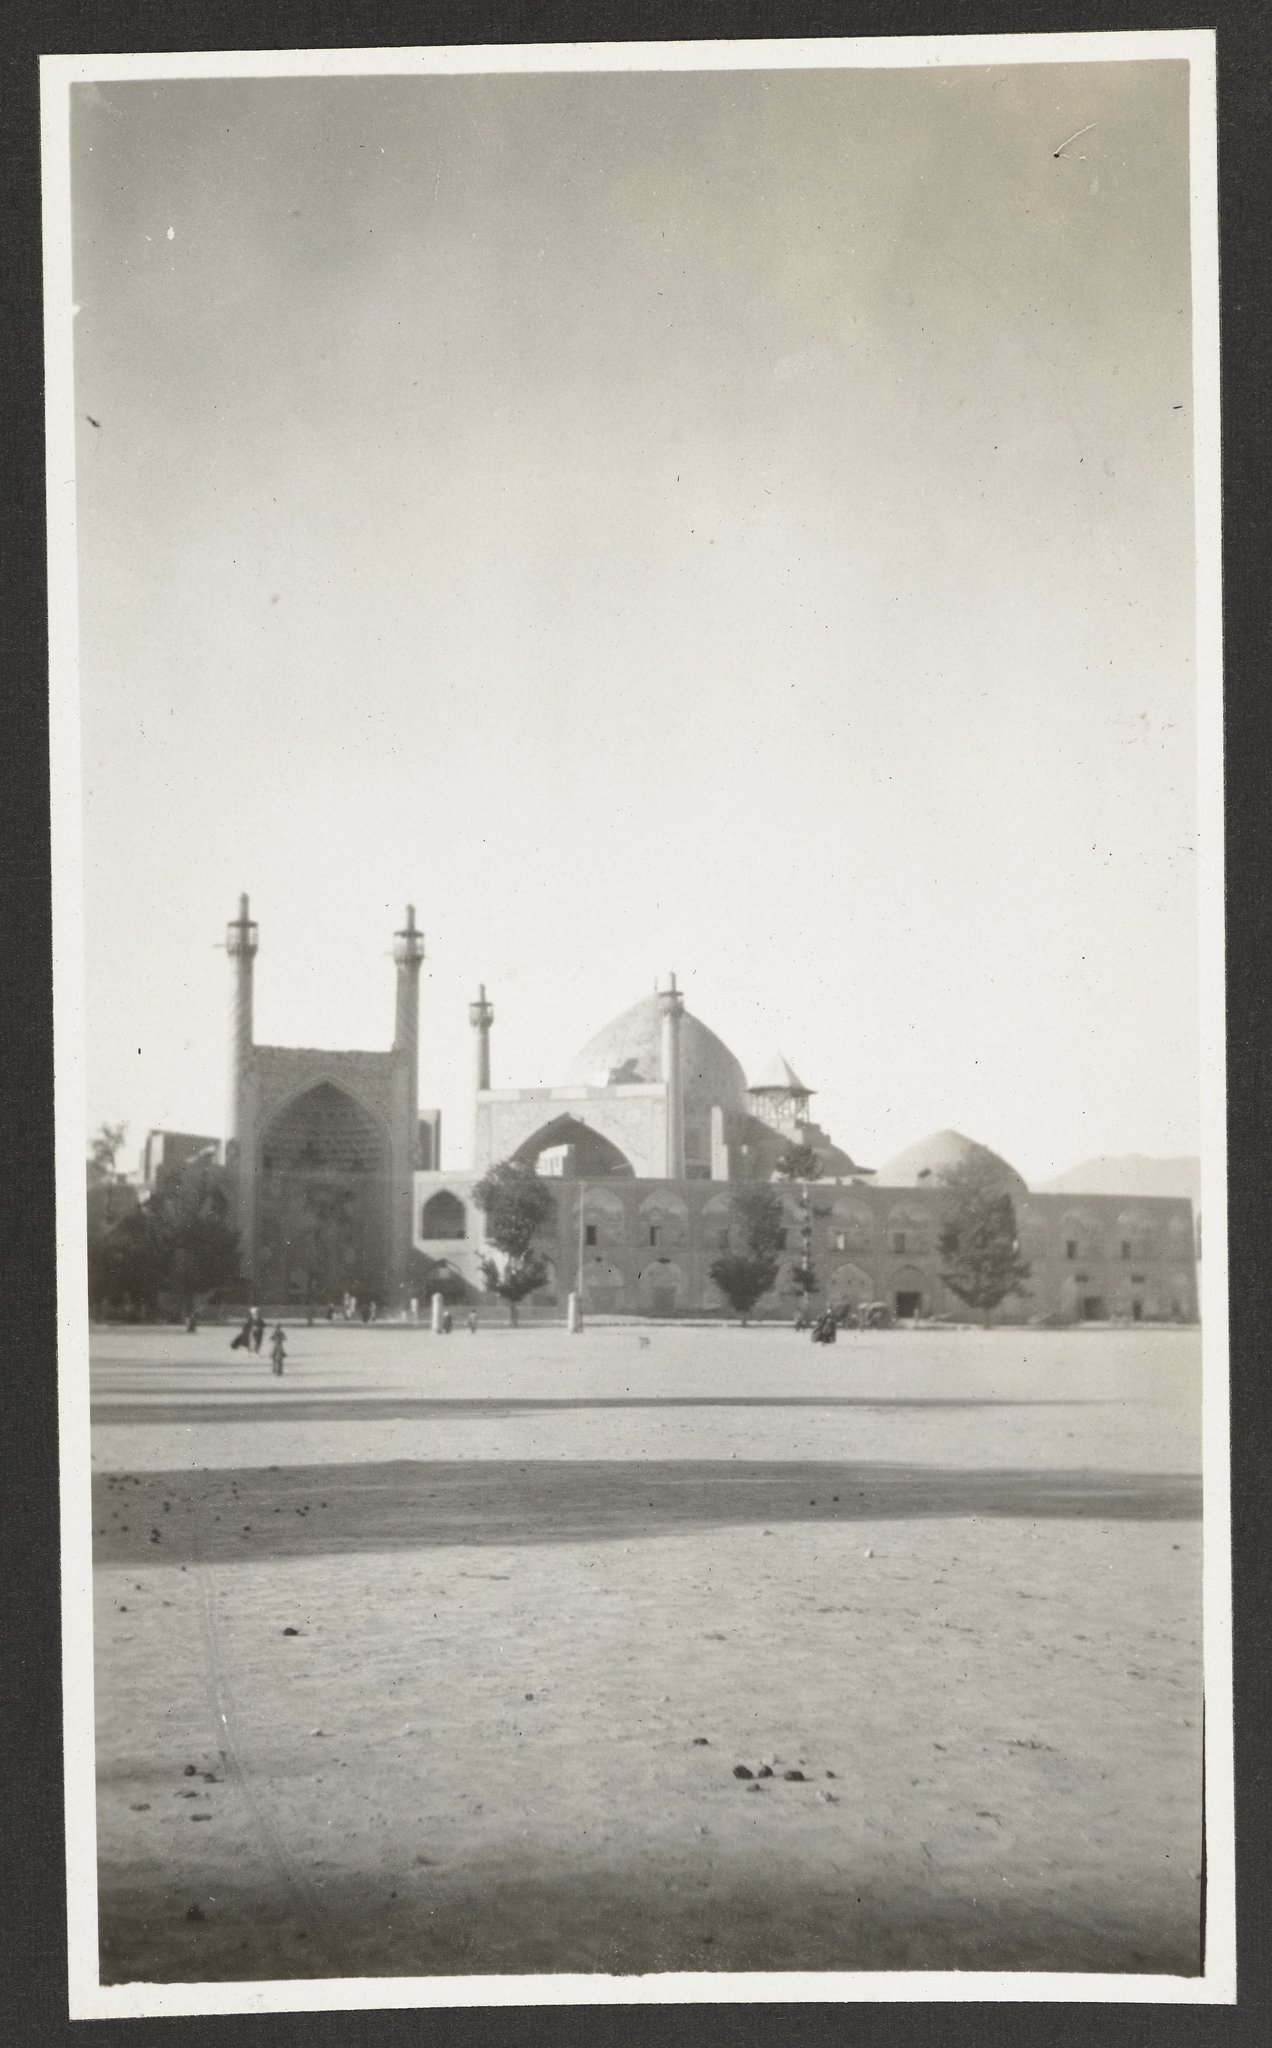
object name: photograph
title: Moskee aan het plein Naghsh-e Jahan, Isfahan, Perzië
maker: a.g.a. van eelde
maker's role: engineer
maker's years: 1862-1950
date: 1925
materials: cardboard, paper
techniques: gelatin silver print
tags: isfahan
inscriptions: number: ‘23.’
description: Titel op object afkomstig uit inventaris (Verklaring der Photo's) behorend bij het album.